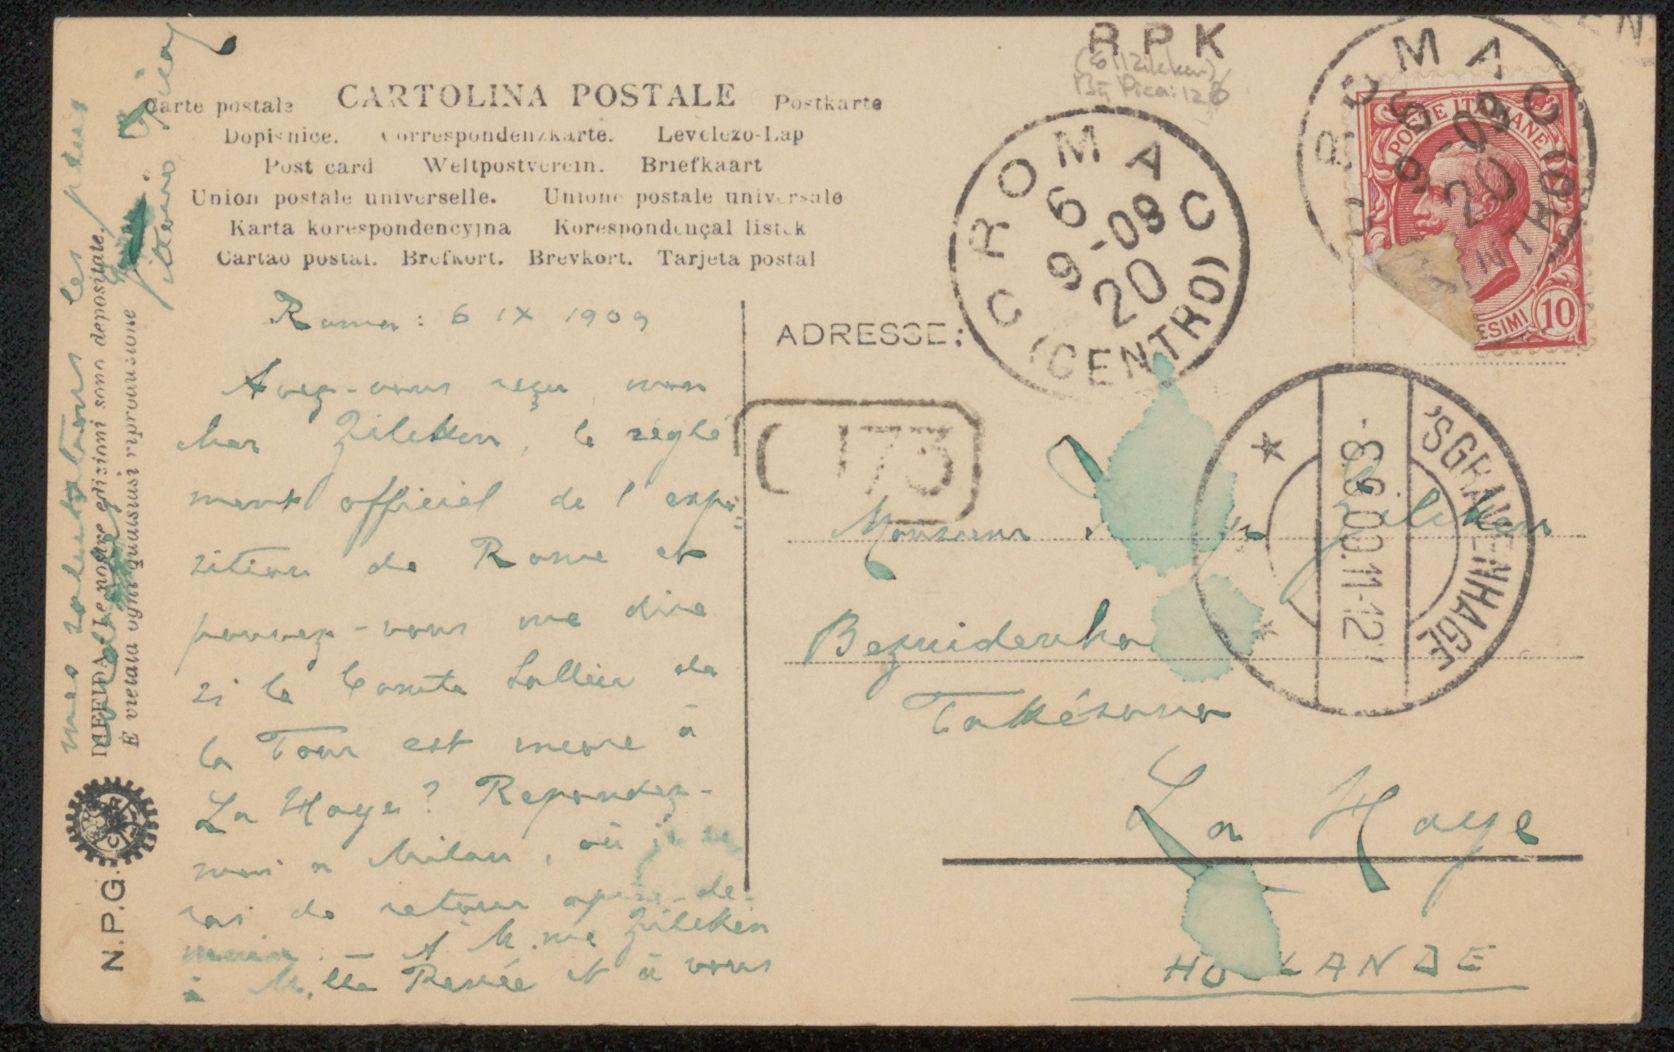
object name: ansichtkaart, prentbriefkaart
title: Prentbriefkaart aan Philip Zilcken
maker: vittorio pica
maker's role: criticus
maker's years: 1864-1930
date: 1909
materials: cardboard, ink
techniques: gelatin silver print, pen, writing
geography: rome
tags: the hague, painter, draughtsman, philip zilcken, exhibition ~ art, rome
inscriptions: collector's mark: ‘RPK’